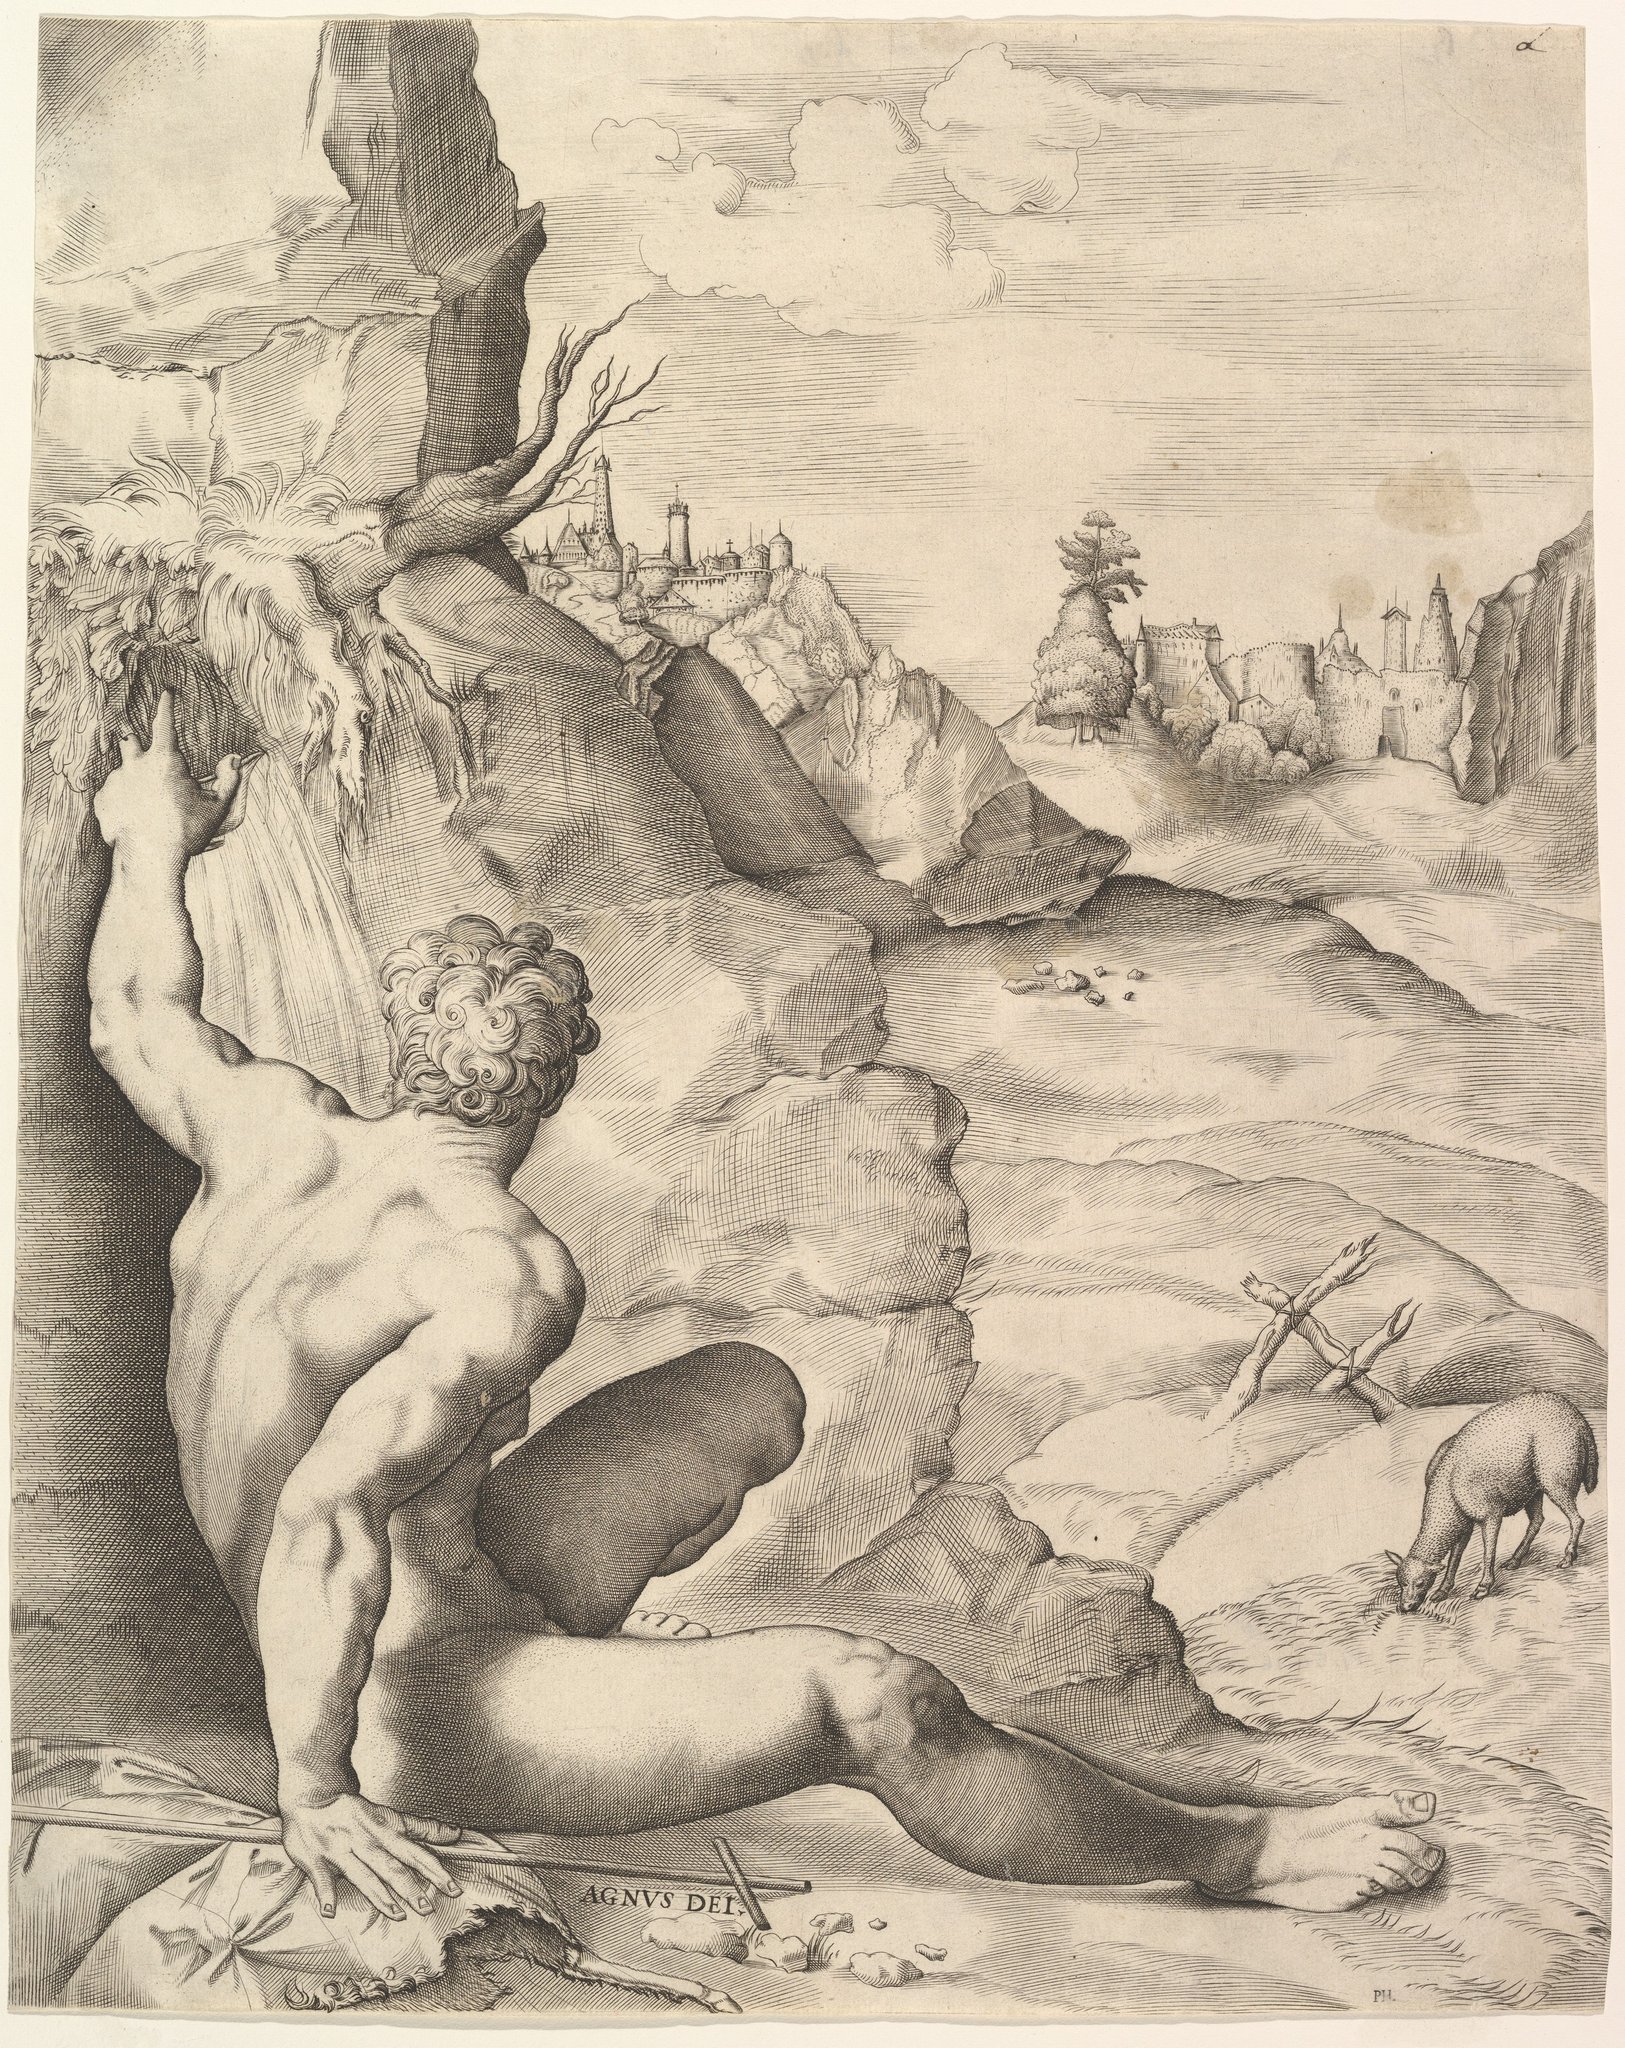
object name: print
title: John the Baptist in the Wilderness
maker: giulio sanuto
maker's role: artist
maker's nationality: italian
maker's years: 1540-1588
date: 1545-1555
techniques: engraving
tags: animals,saint john the baptist